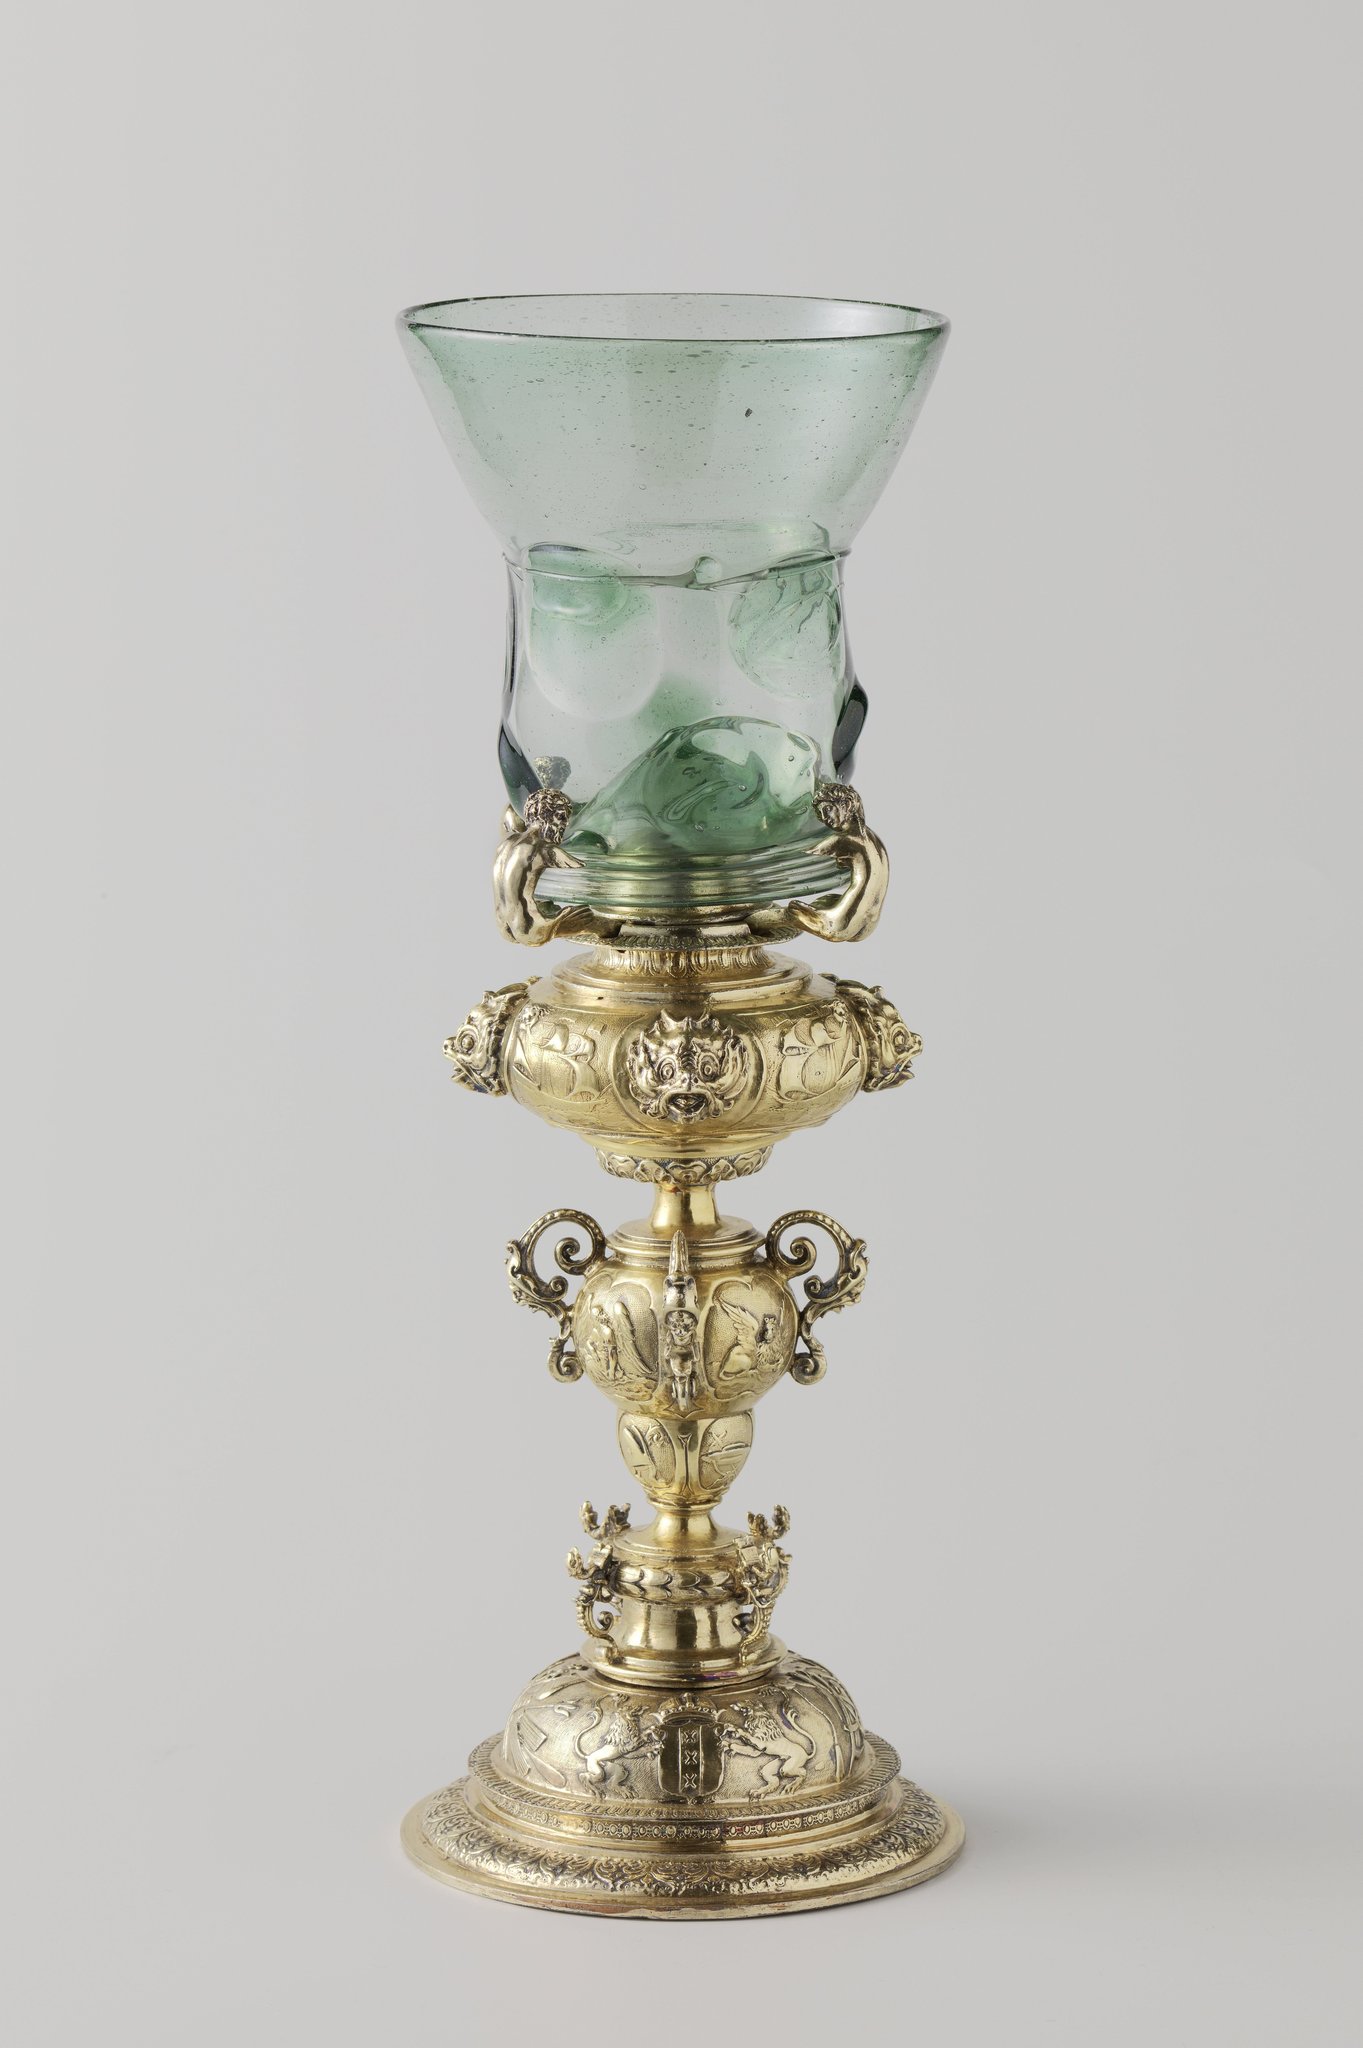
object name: berkenmeier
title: Berkemeyer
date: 1625-1675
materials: glass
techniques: glassblowing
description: A Berkemeyer is a wine glass with a wide, low stem and a flaring conical bowl. Its form is thought to derive from wooden beakers carved from birch. The prunts on the stem (blobs of molten glass applied to the surface) afforded a better grip. At a time when forks were not in common use and people often had greasy fingers, this was not a superfluous luxury.